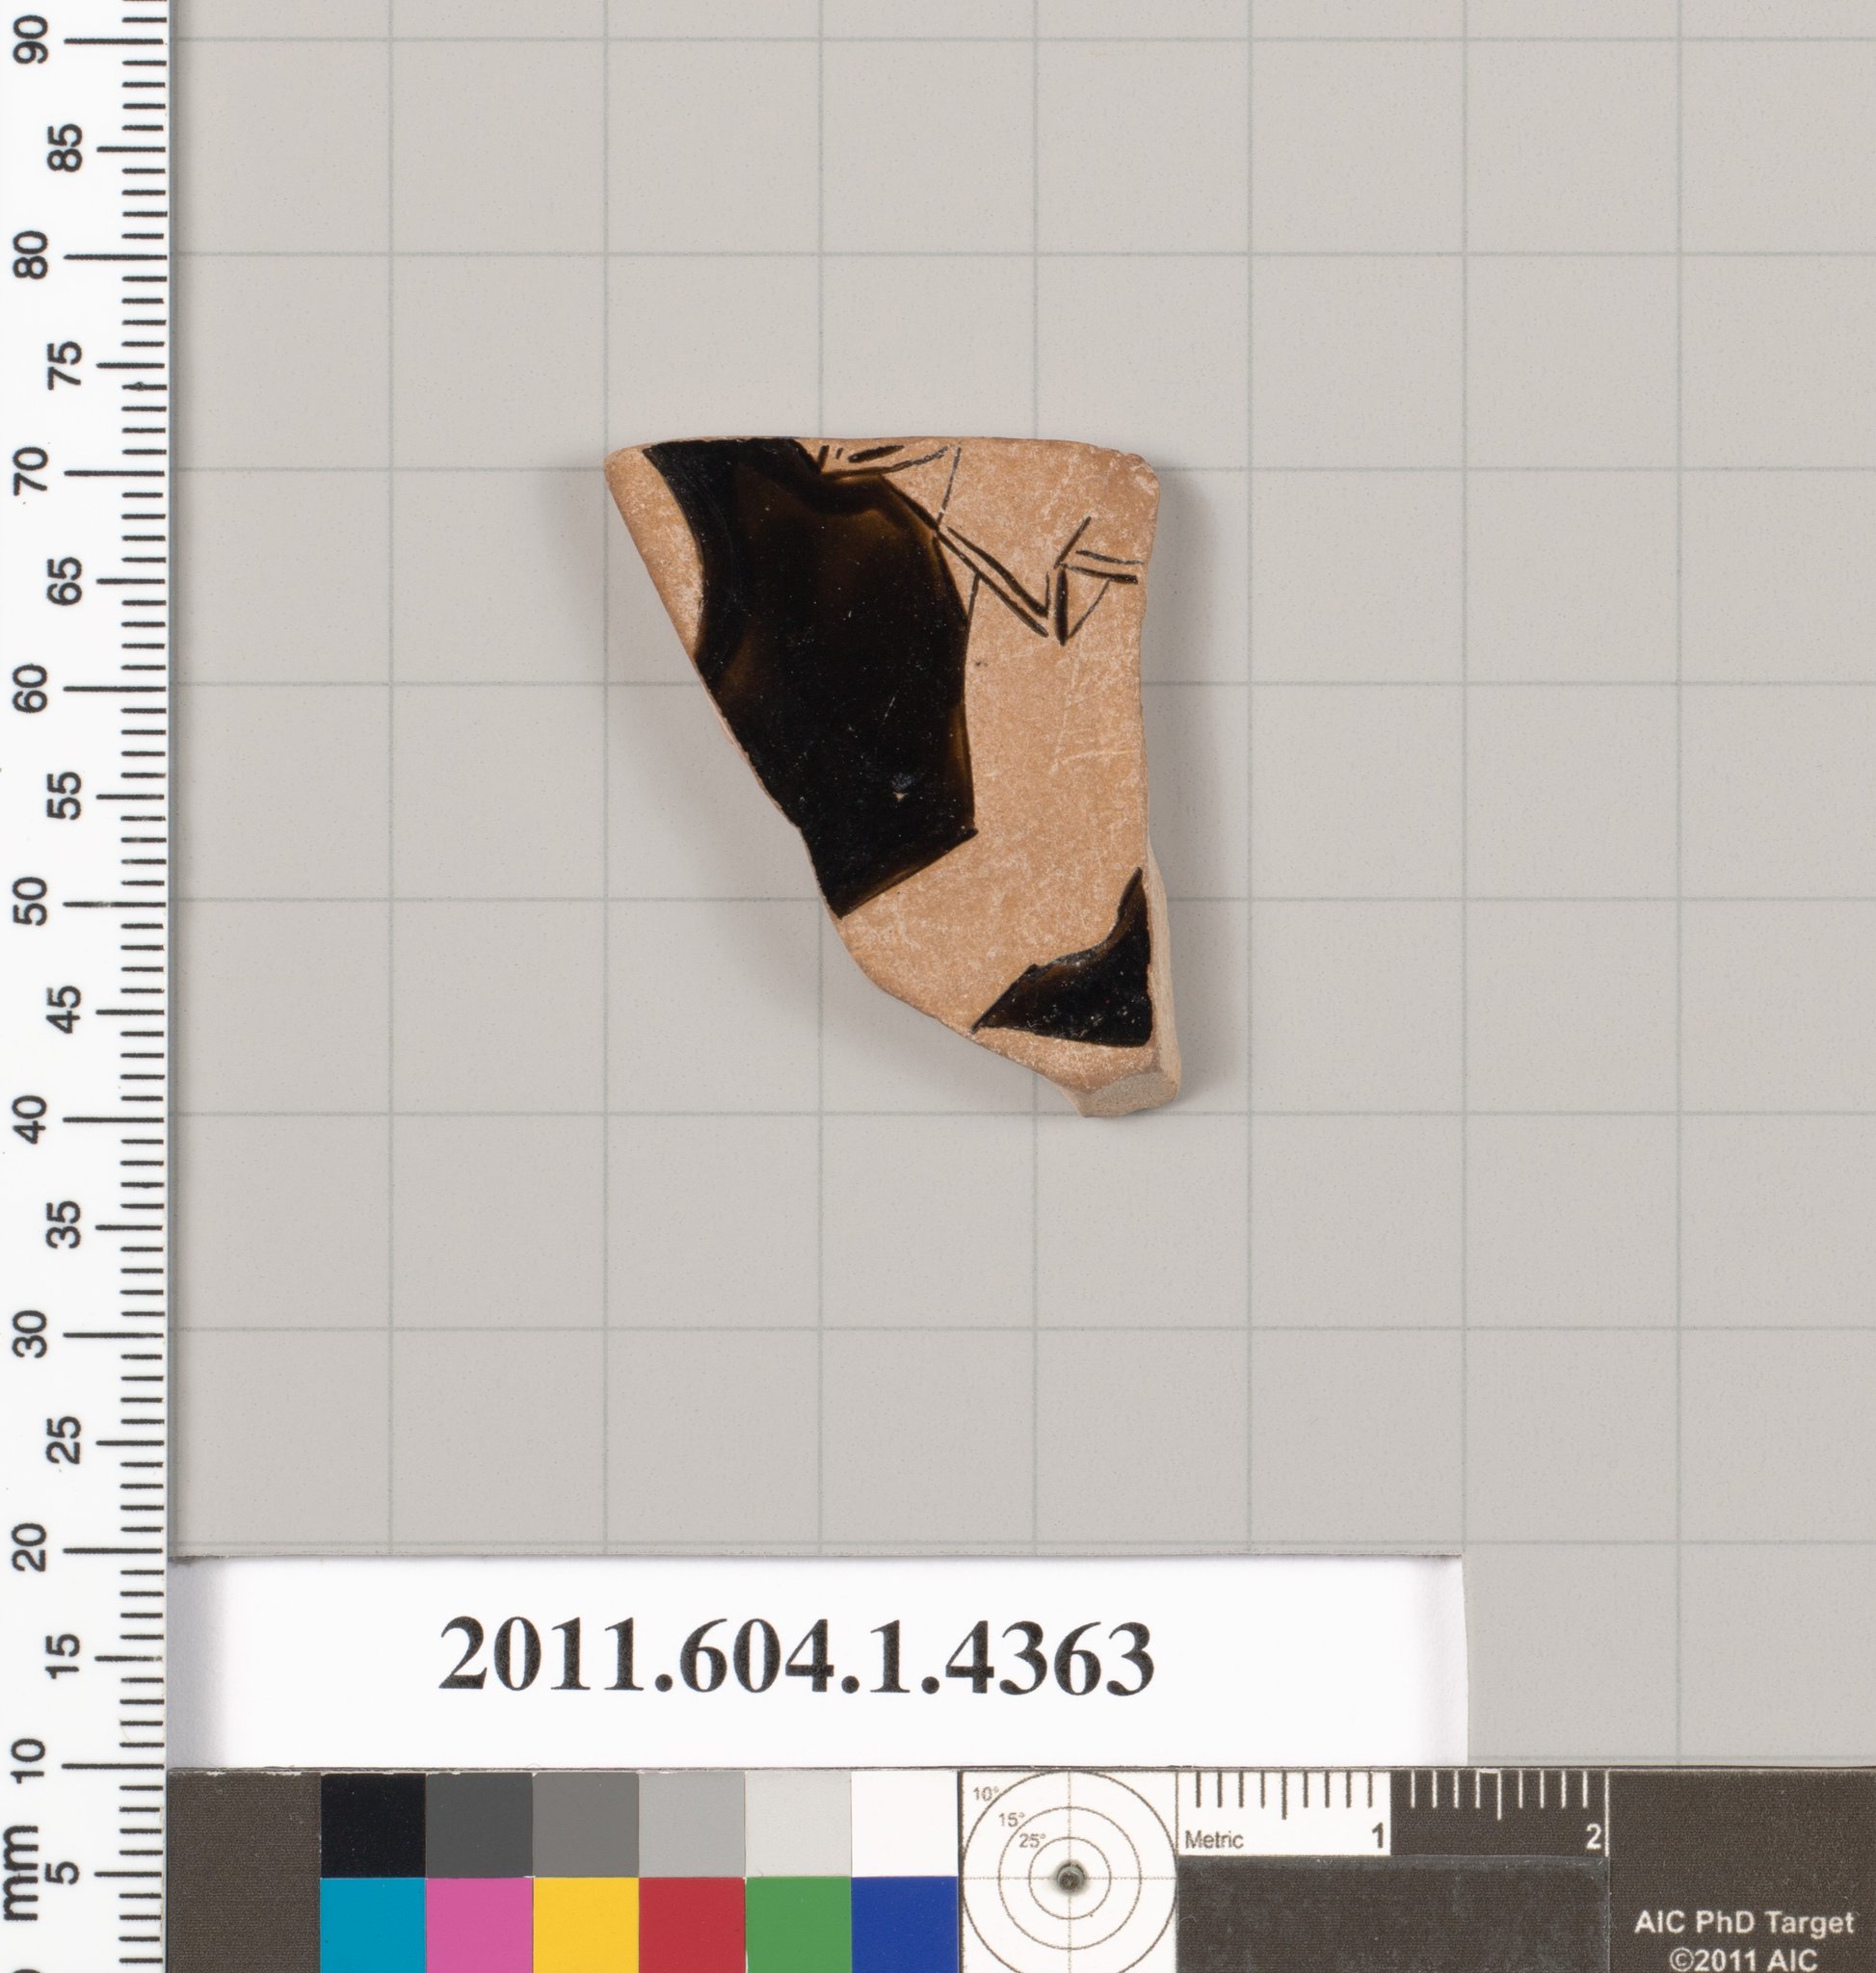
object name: kylix fragment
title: Terracotta fragment of a kylix (drinking cup)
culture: greek, attic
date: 510-480 BCE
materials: terracotta